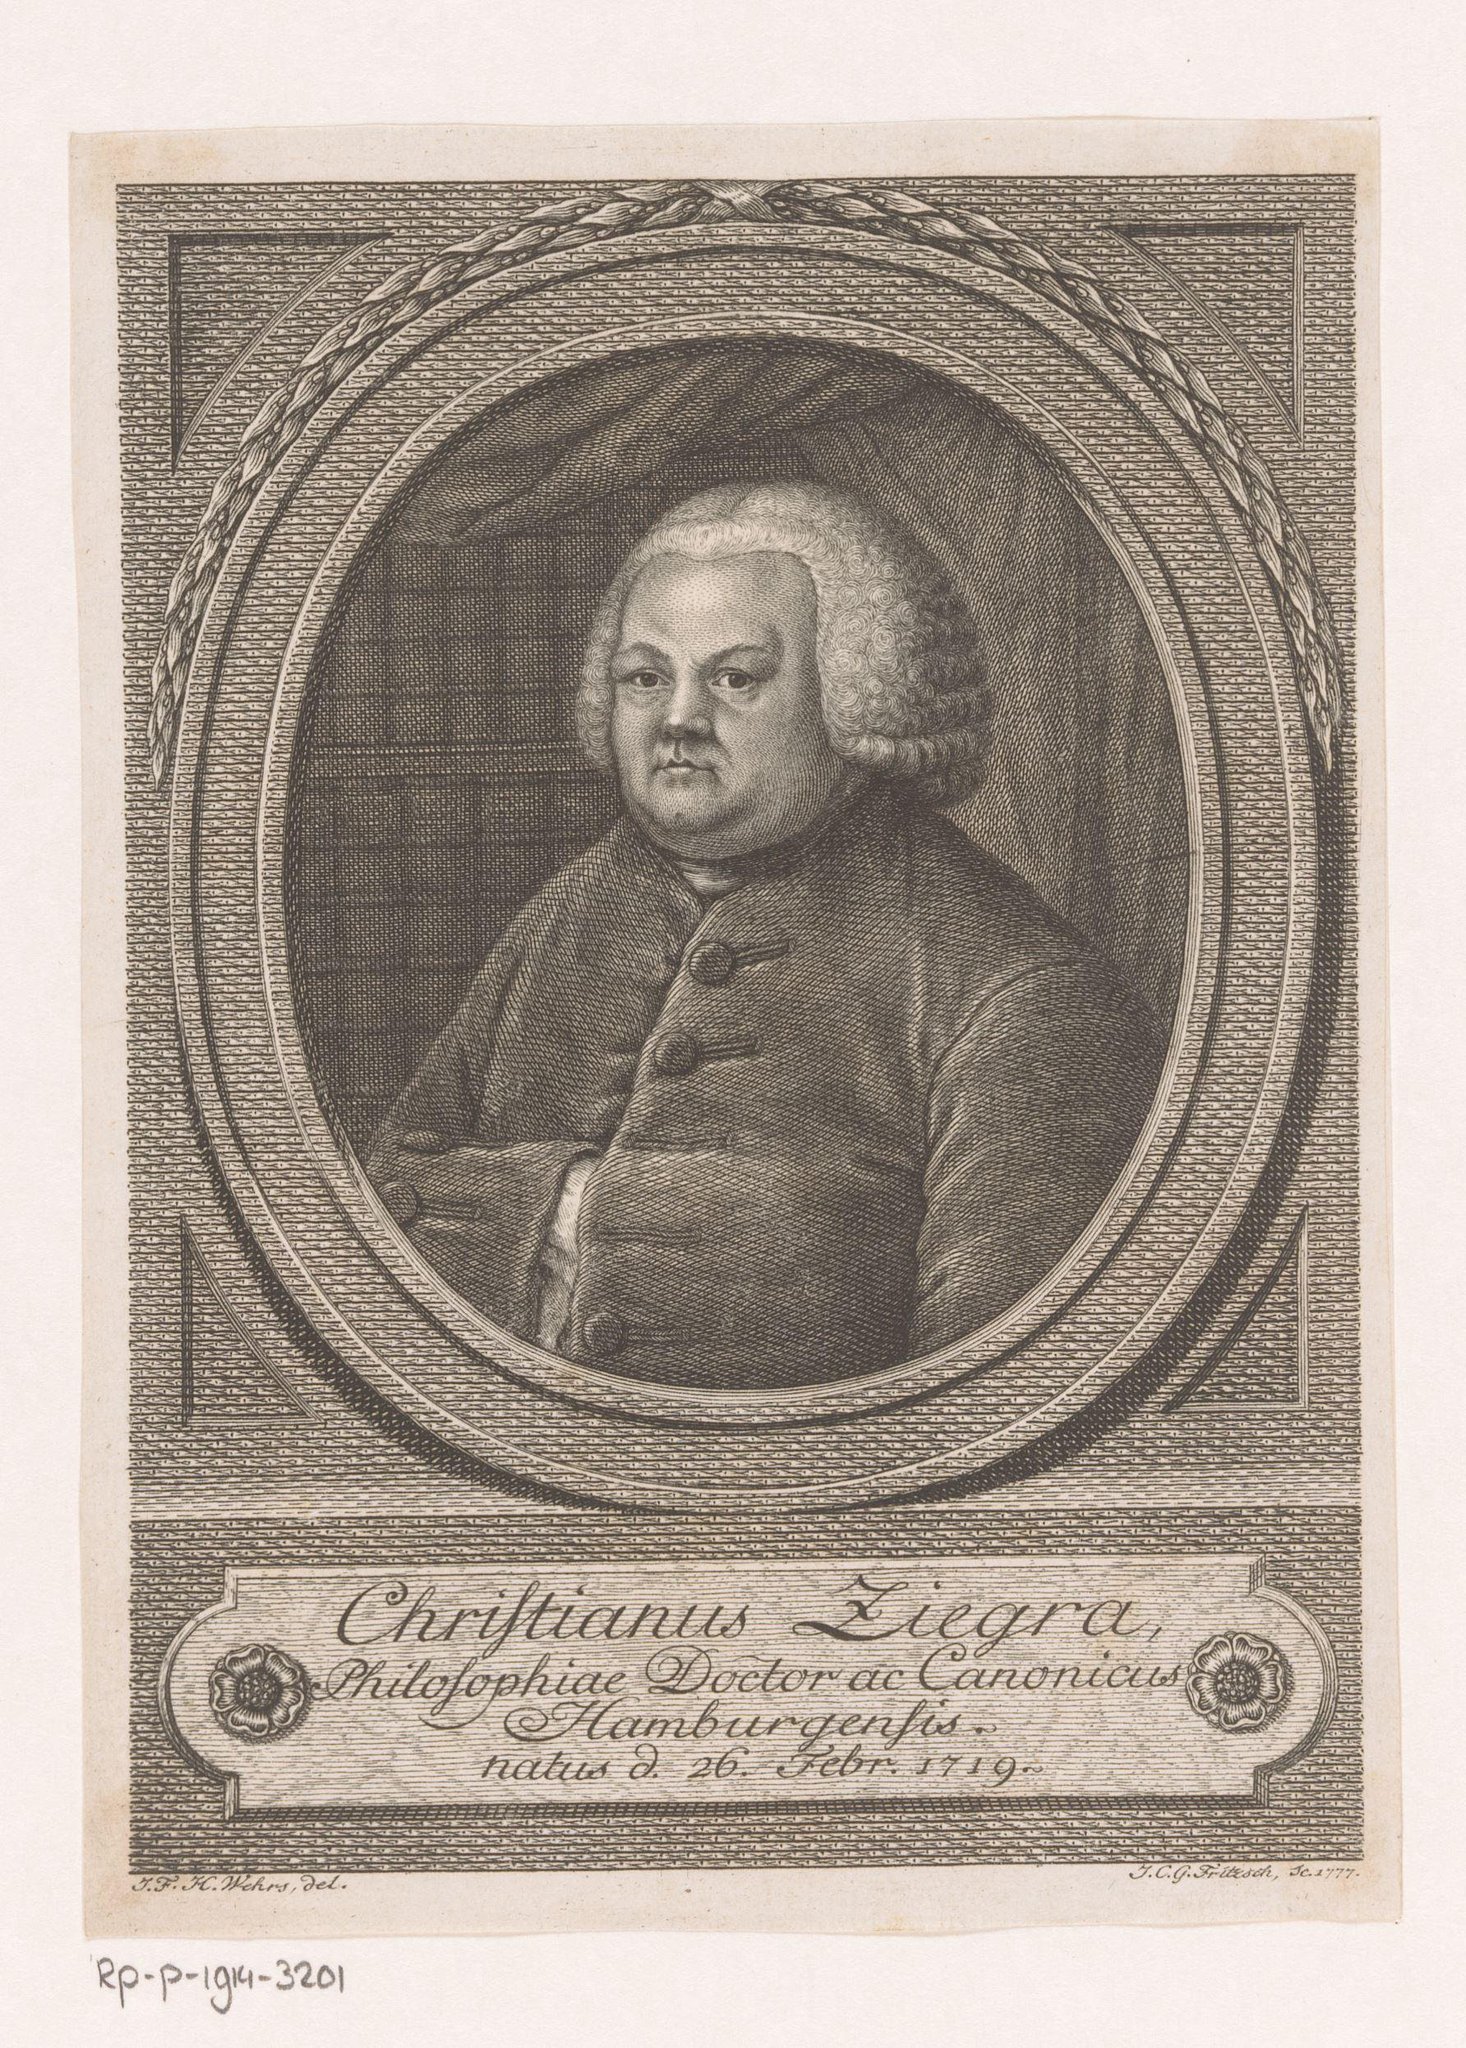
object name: print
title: Portret van Christian Ziegra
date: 1777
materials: paper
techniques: engraving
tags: bookshelves, ornament ~ medallion, historical persons, ornament ~ festoon, garland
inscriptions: collector's mark: Lugt 2228